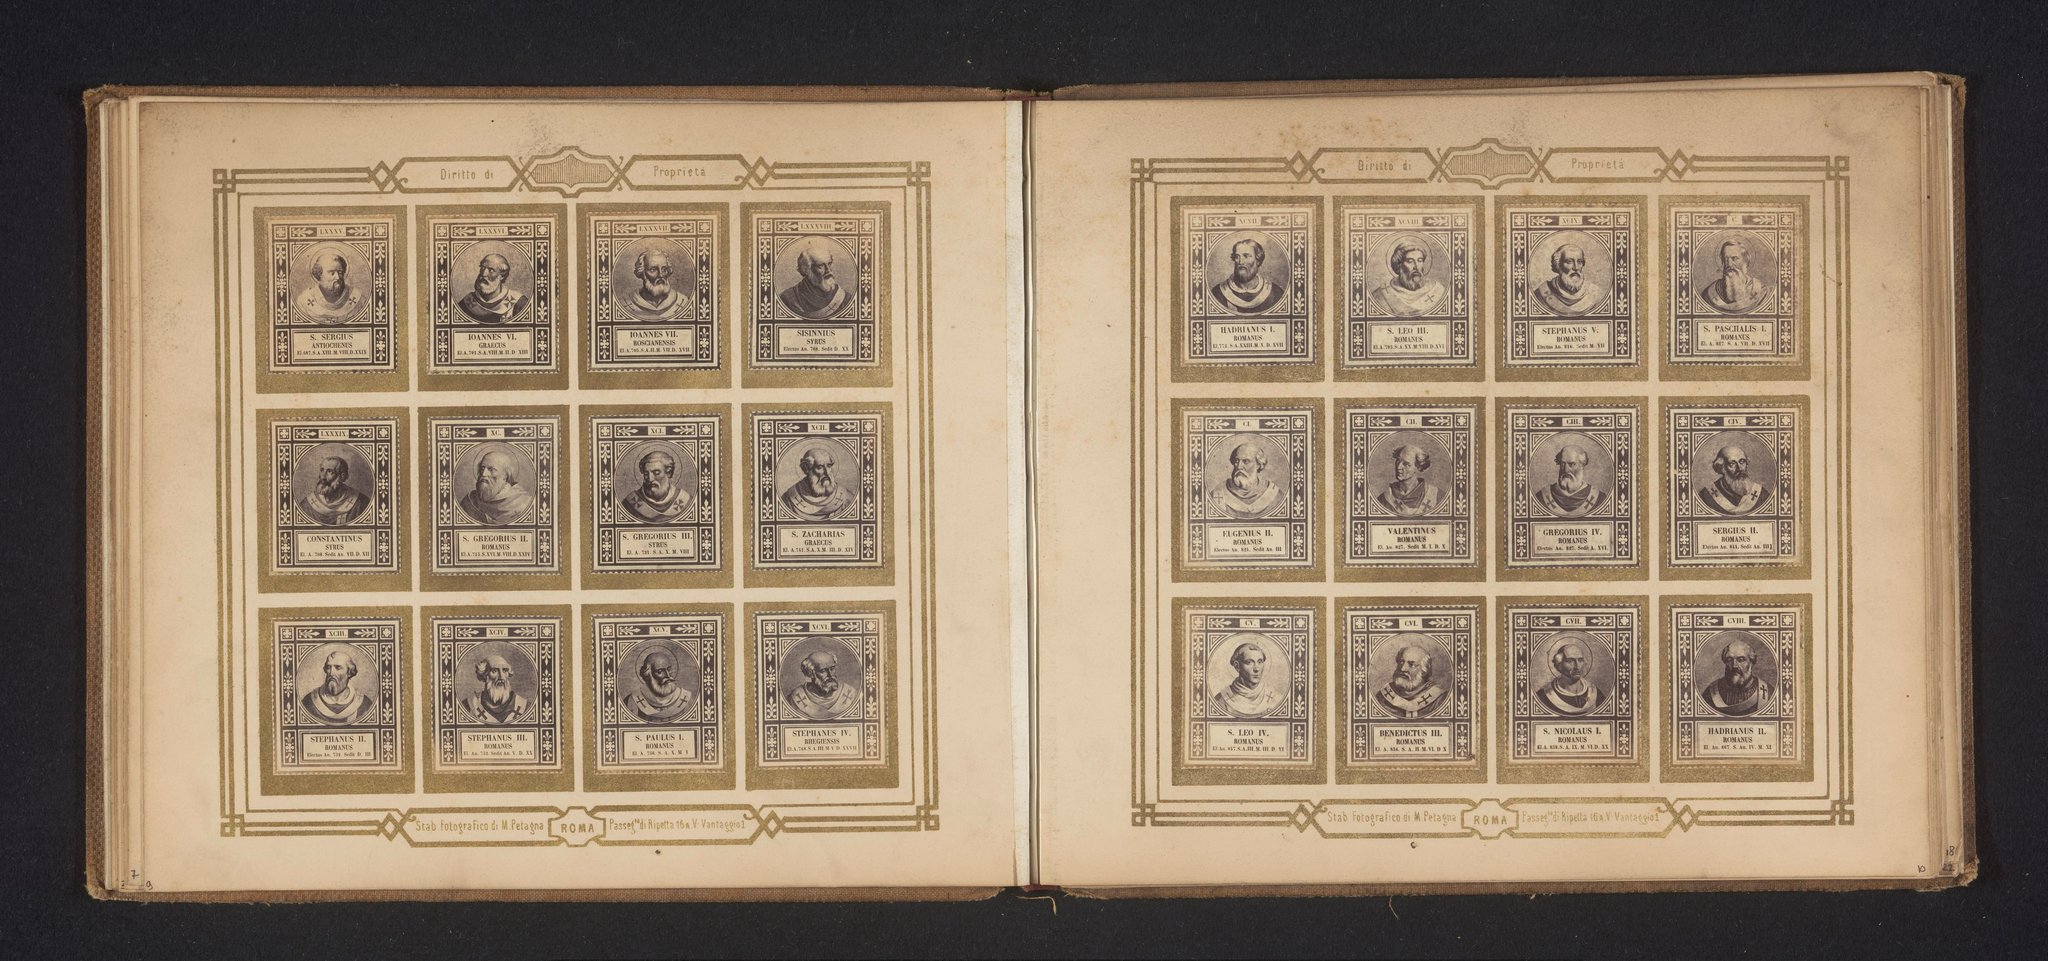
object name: reproduction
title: Fotoreproductie van twaalf portretten van pausen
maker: m. petagna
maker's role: fotograaf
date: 1854-1864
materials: photographic support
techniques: albumen print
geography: rome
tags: pope